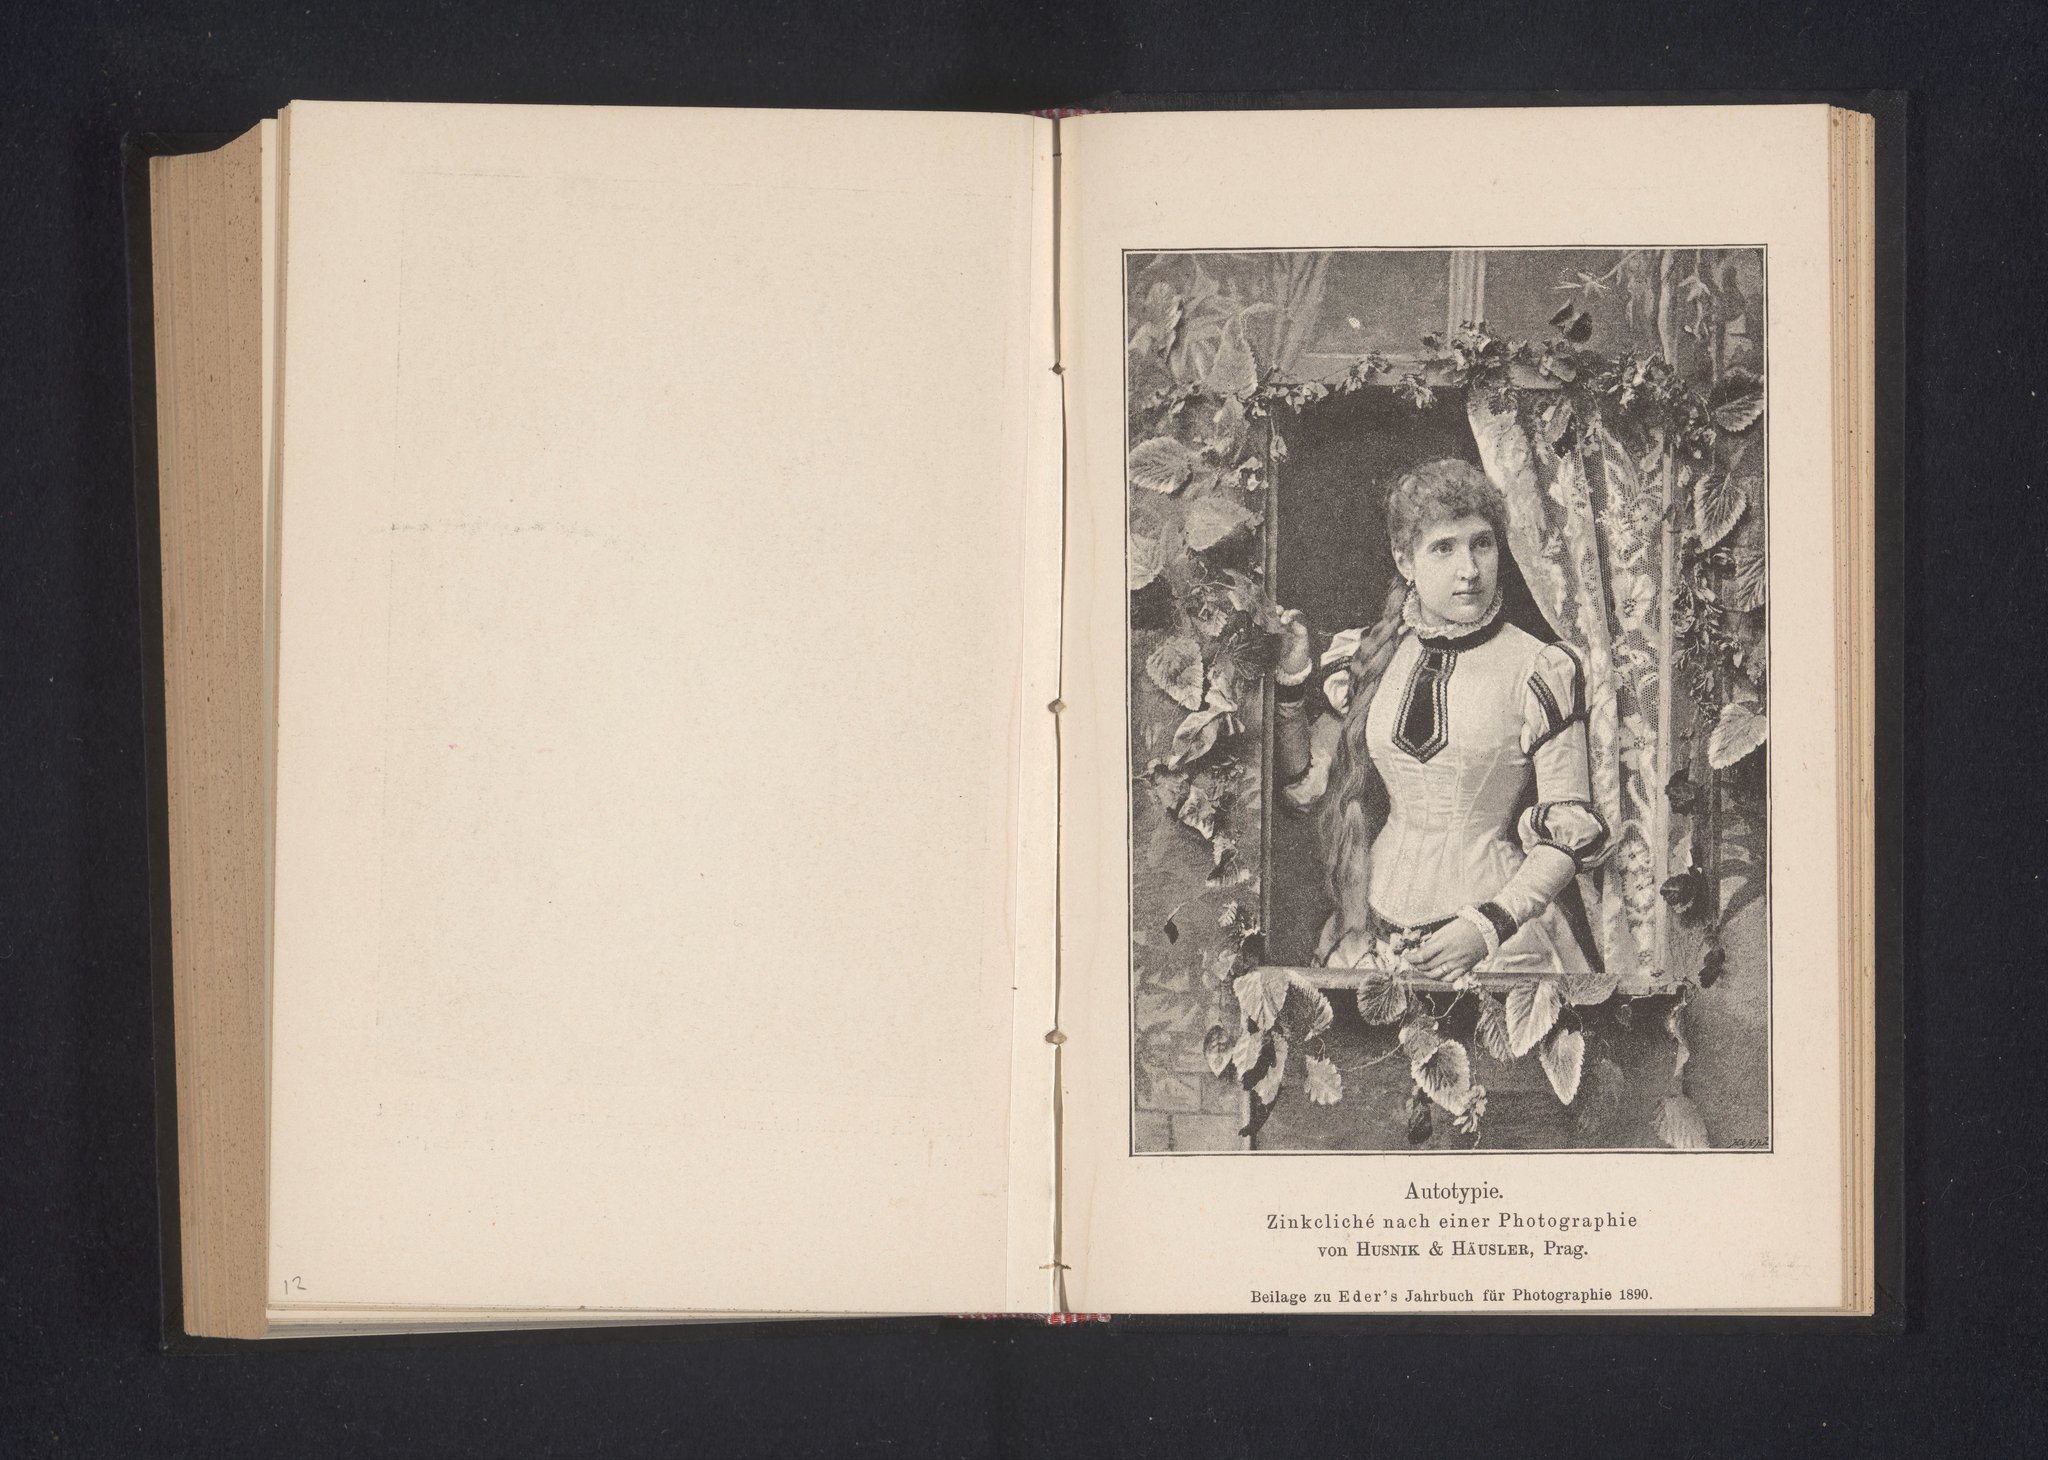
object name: page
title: Portret van een onbekende vrouw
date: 1885-1890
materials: paper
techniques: autotype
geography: prague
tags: historical persons - bb - woman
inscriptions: monogram: ‘[...]’, inscription: ‘Autotypie/ Zinkcliché nach einer Photographie von Husnik & Häusler, Prag./ Beilage zu Eder's Jahbruch für Photographie 1890’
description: Prent op zevenentwintigste ongenummerde pagina na pagina 400.